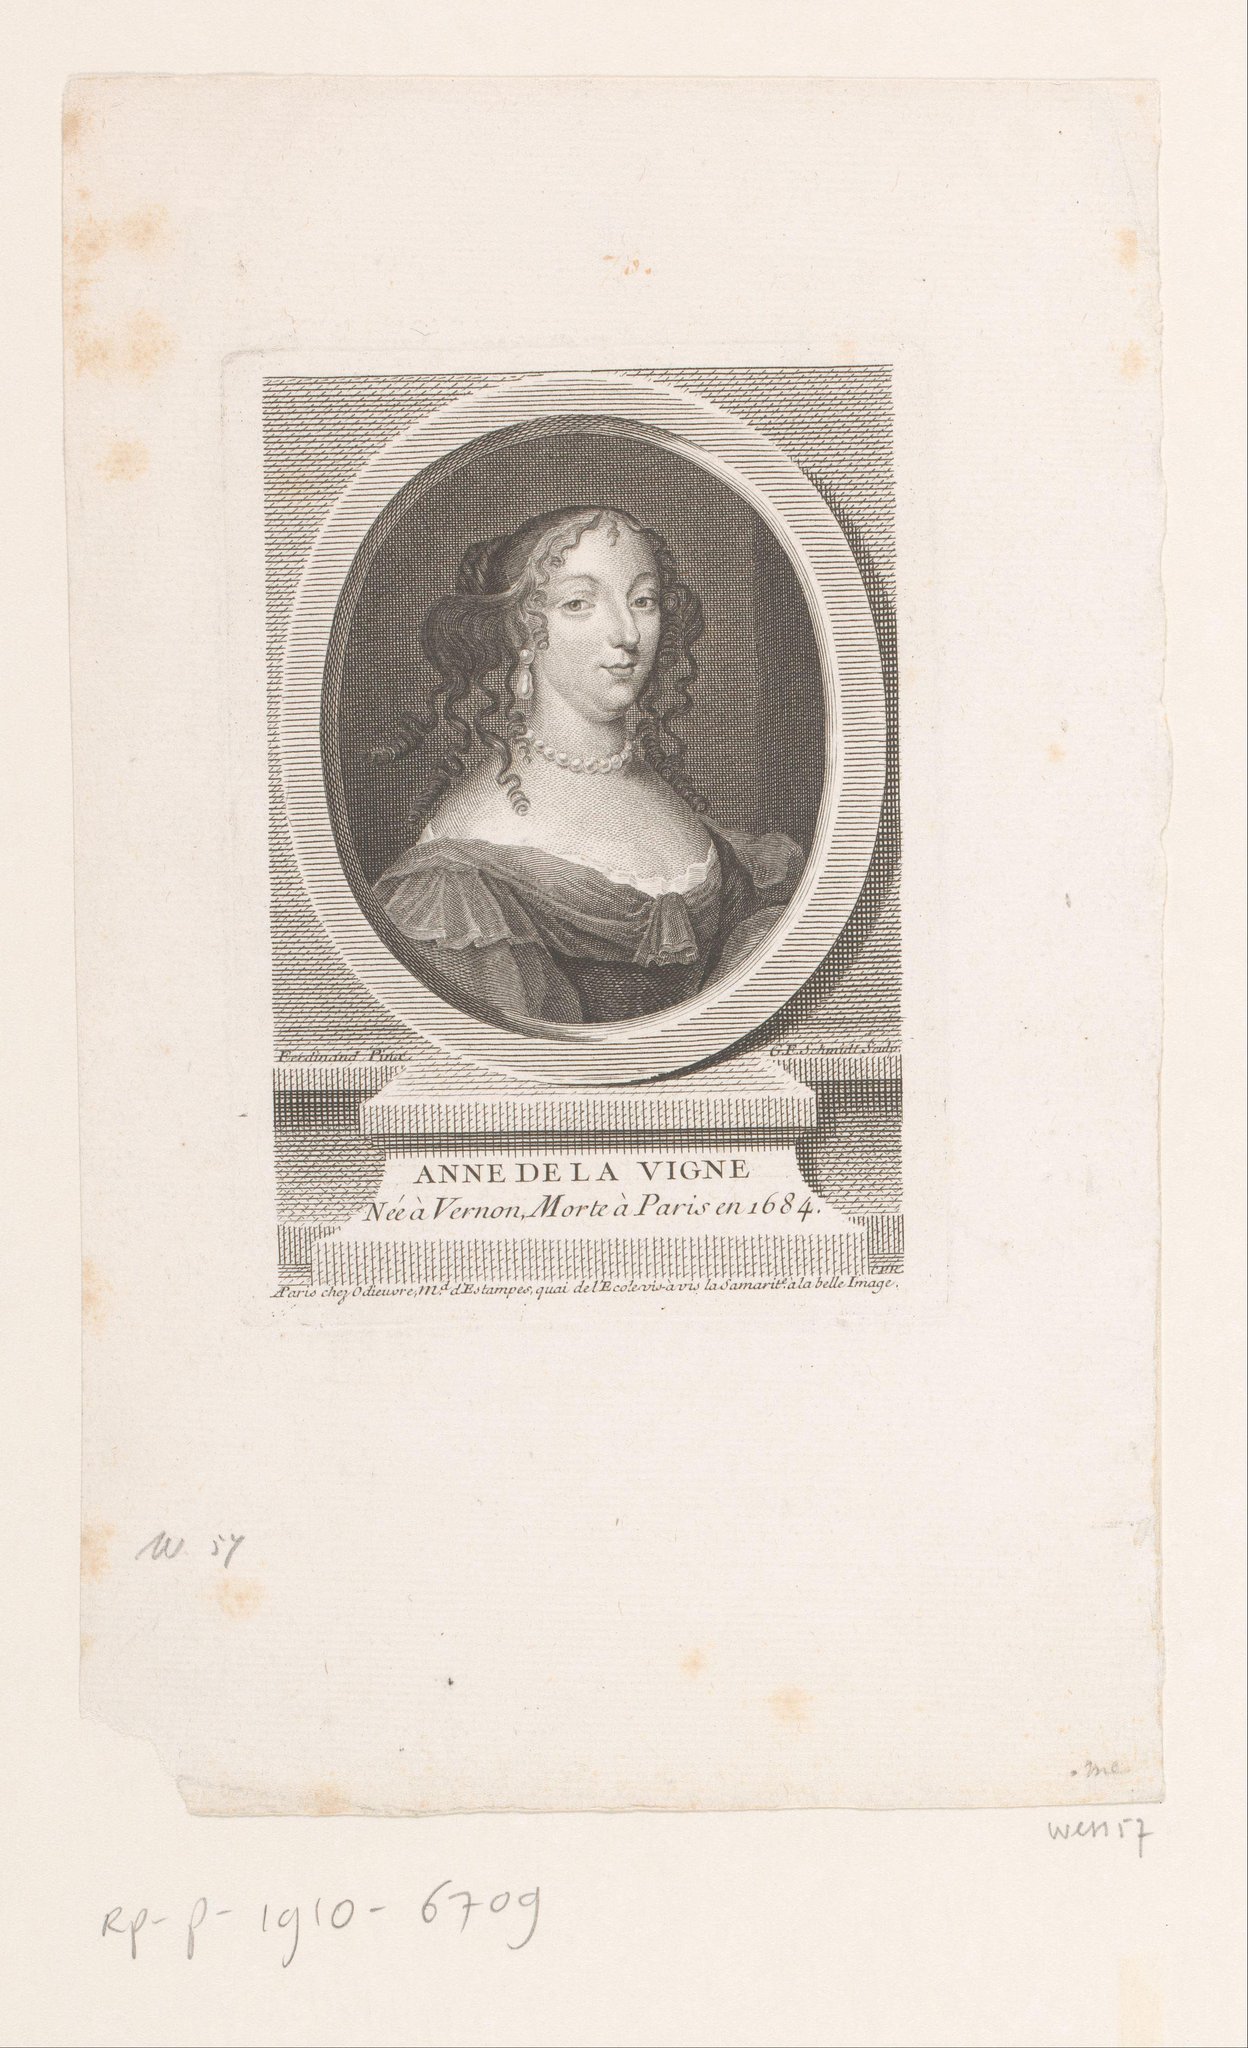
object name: print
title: Portret van Anne de la Vigne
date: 1722-1775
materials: paper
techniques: engraving, etching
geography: paris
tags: paris, historical persons - bb - woman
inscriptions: collector's mark: Lugt 2228